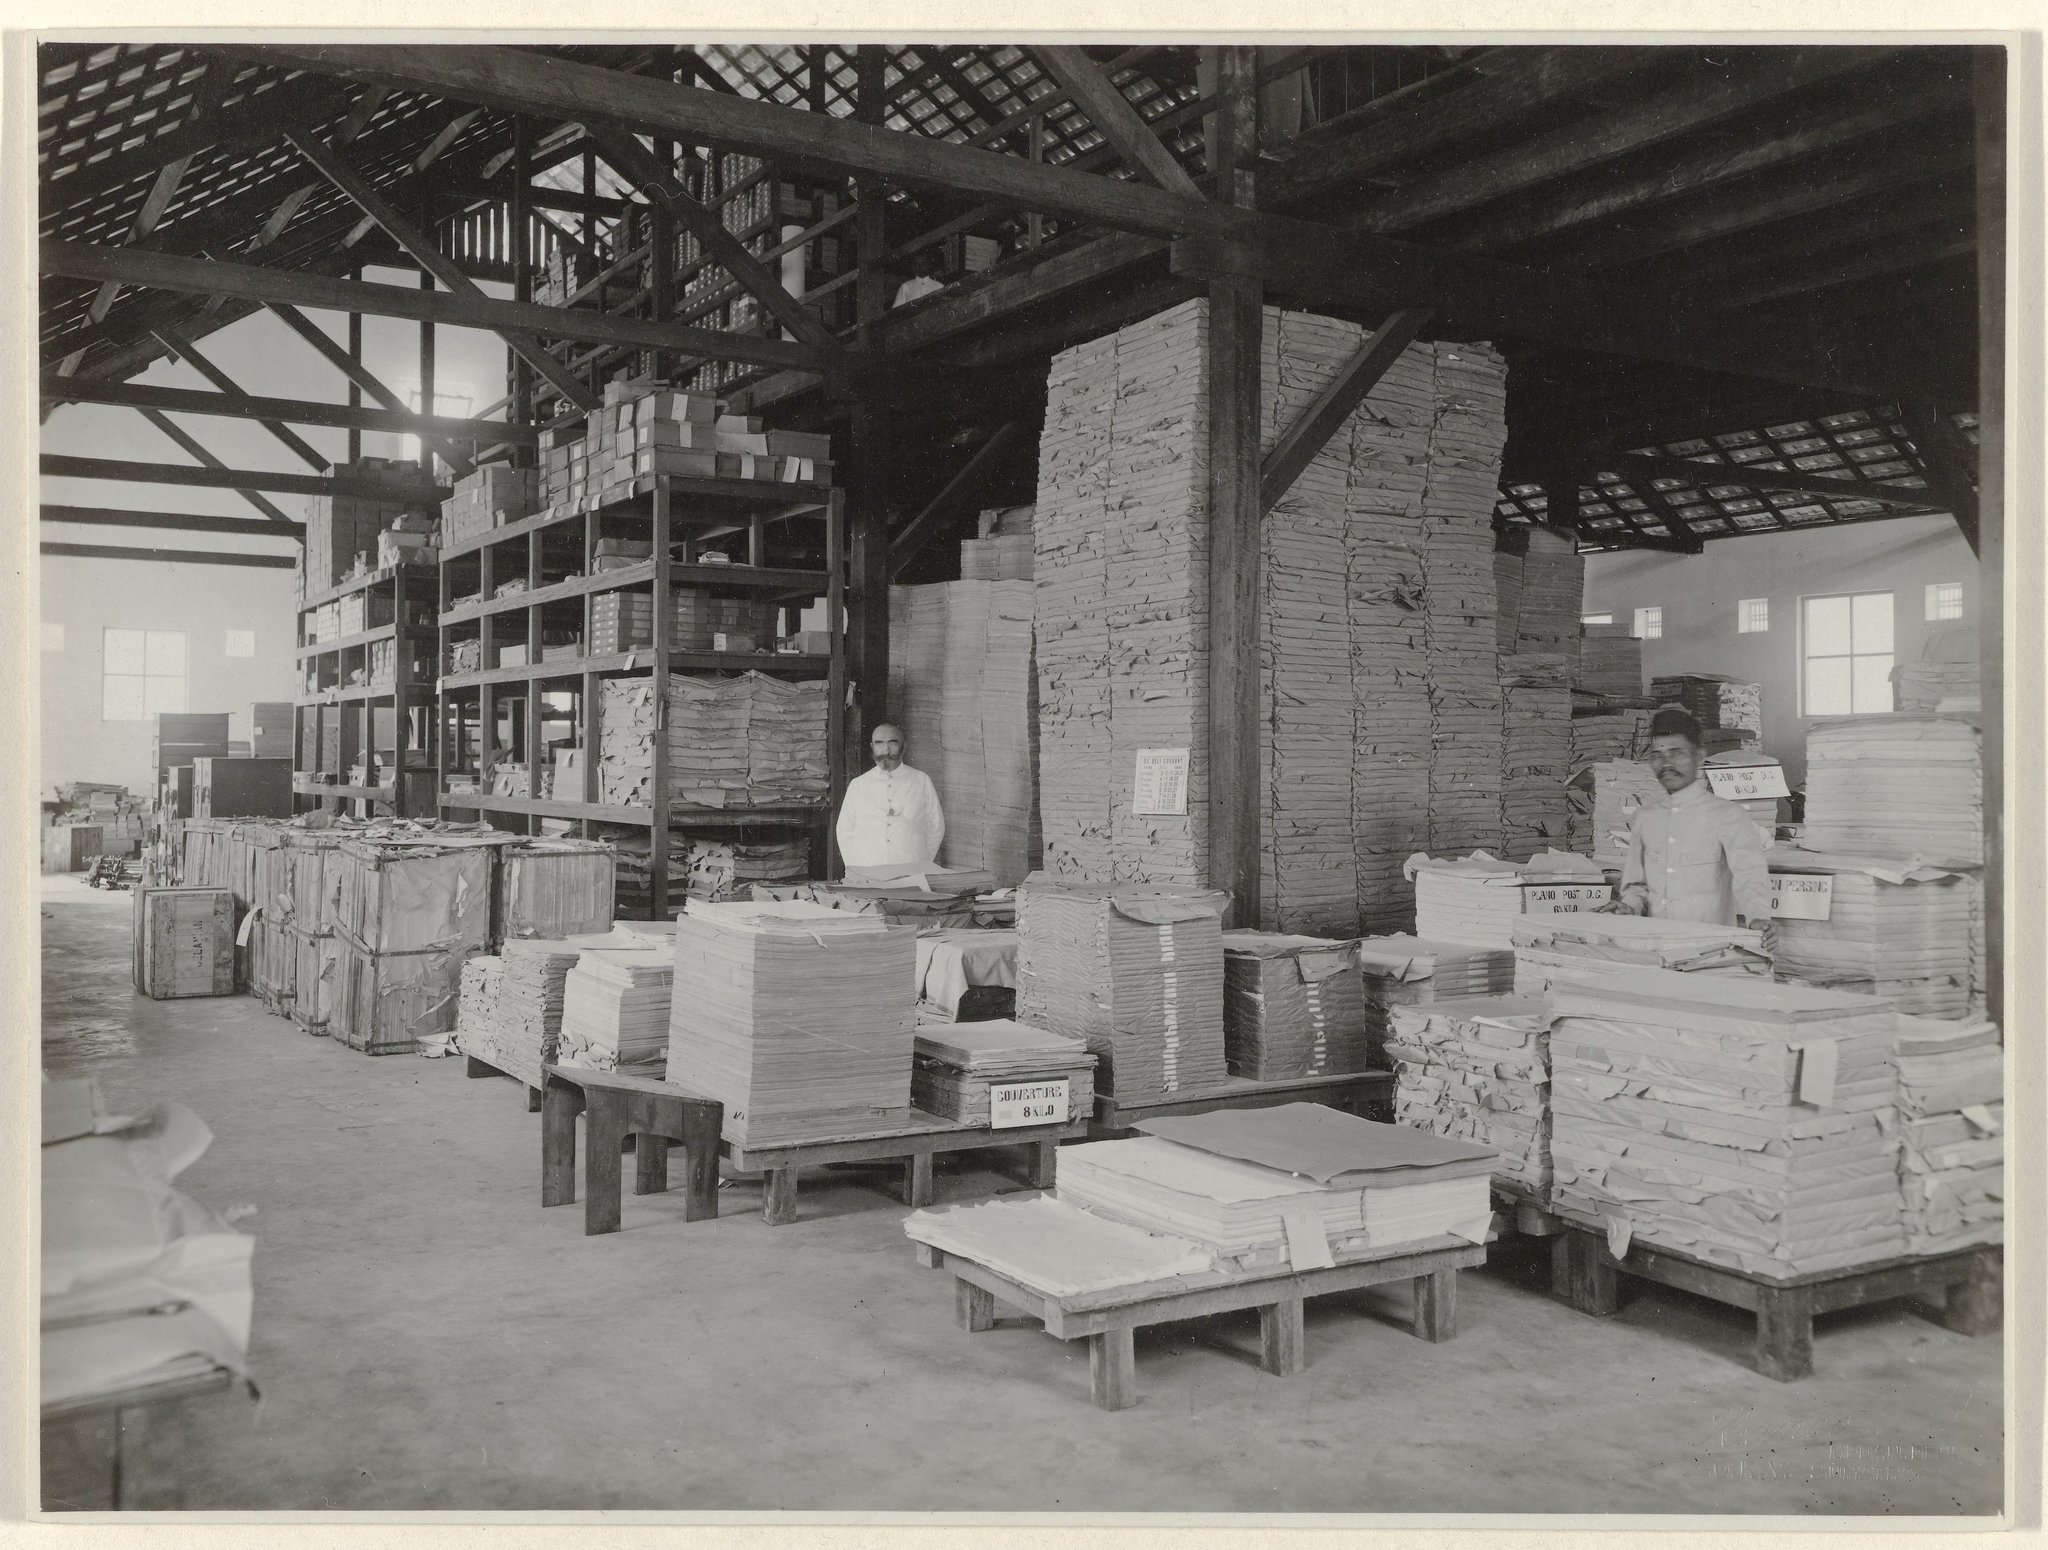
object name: photograph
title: Pakhuis met papier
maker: t. kaneo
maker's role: fotograaf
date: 1921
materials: photographic support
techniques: gelatin silver print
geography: medan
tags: dutch east indies, the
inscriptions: inscription: ‘Papier pakhuis’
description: Het pakhuis met de voorraden papier op de drukkerij van de Deli Courant in Medan. Onderdeel van een groep van 18 foto's uit 1921 binnen de groep van 49 losse zwart-wit foto's van verschillend formaat over de uitgeverij en drukkerij van de krant Deli Courant in Medan in de periode 1885-1947.